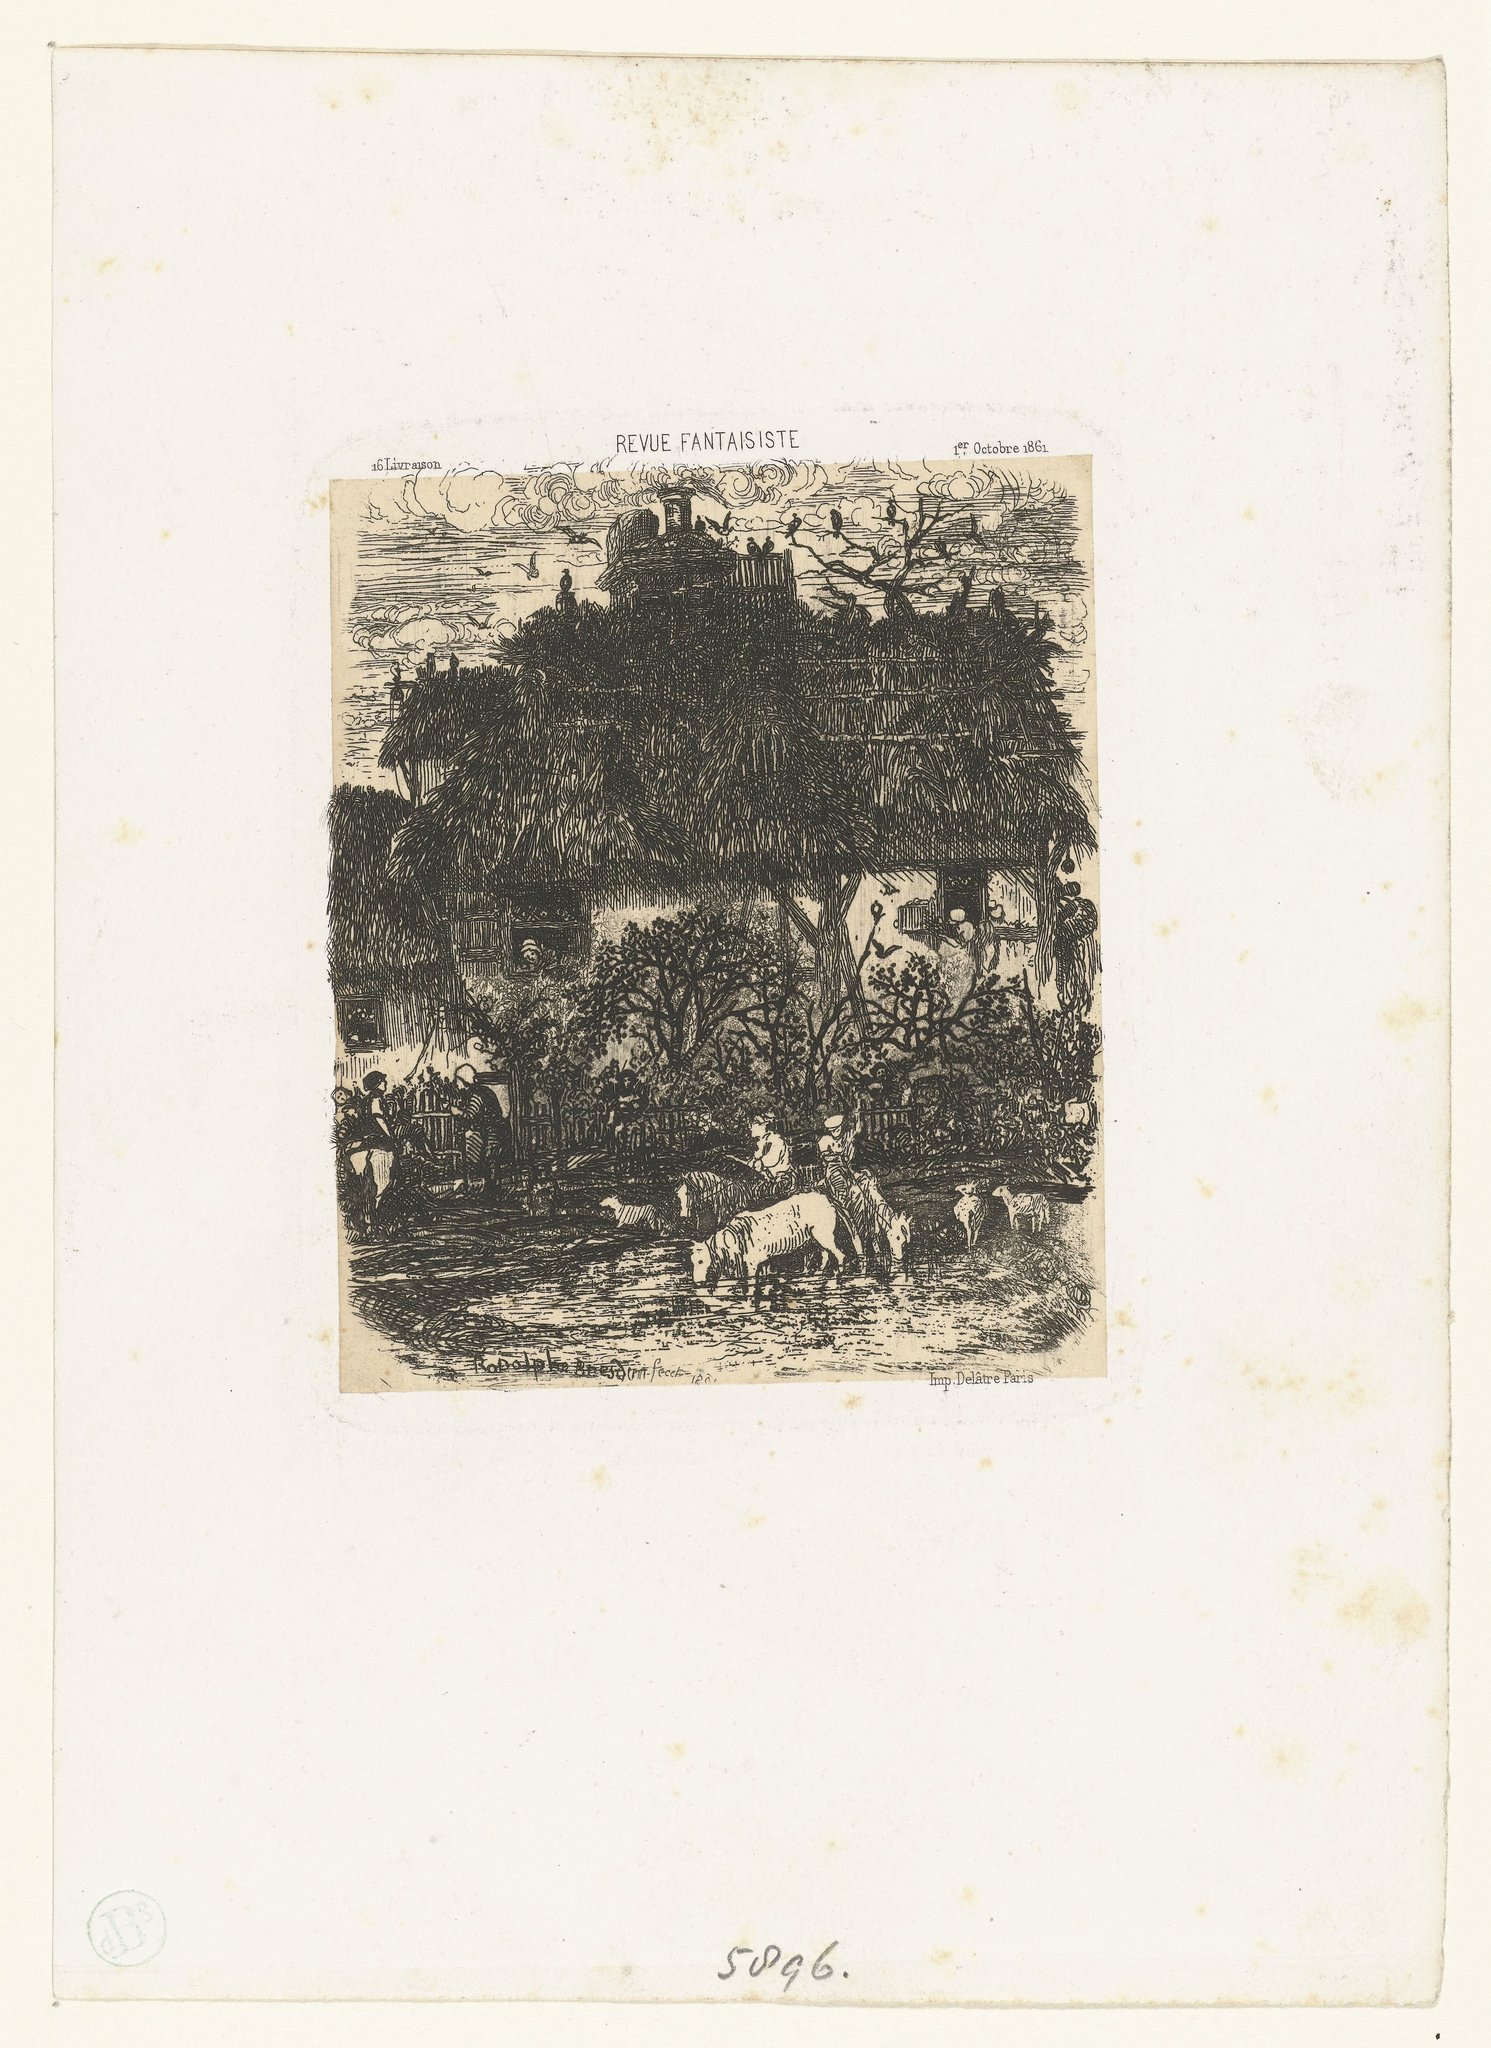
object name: print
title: La ferme couverte de chaume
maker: rodolphe bresdin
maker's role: draughtsman, print maker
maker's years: 1822-1885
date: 1861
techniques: printmaking, etching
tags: farm or solitary house in landscape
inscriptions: collector's mark: Lugt 733, collector's mark: Lugt 2228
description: Boerderij gelegen aan een zandweg. Bovenop het rieten dak staat een duiventil. Bij een plas water op de voorgrond laten twee ruiters hun schapen en paarden drinken. Boven de voorstelling staat de tekst Revue Fantaisiste.